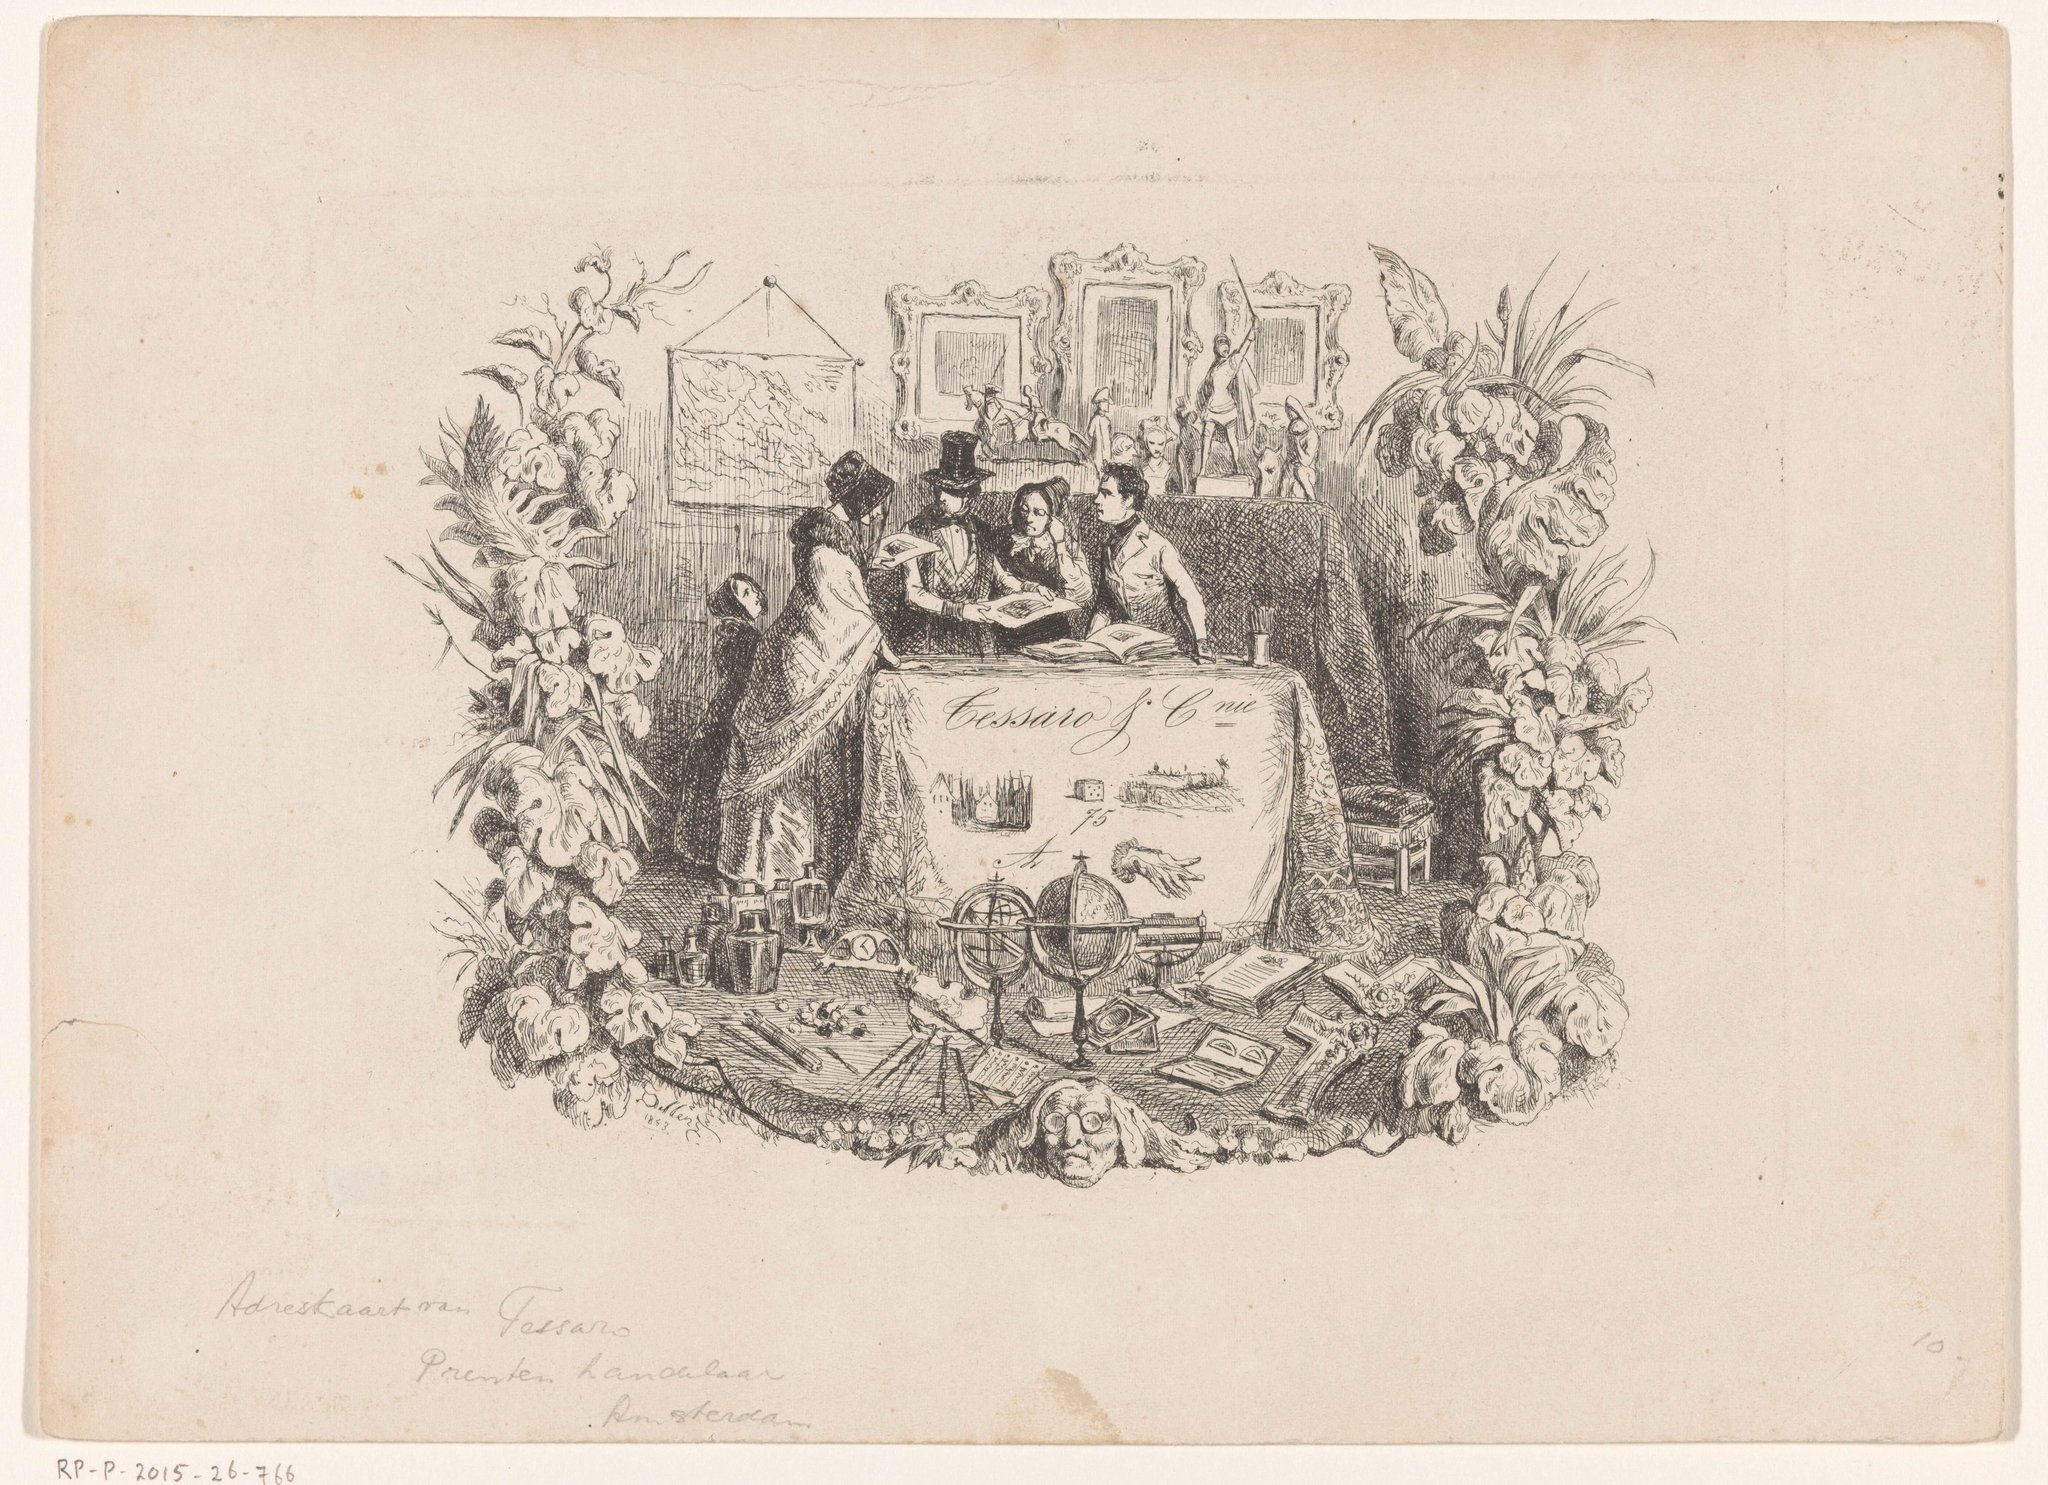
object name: print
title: Interieur van prenthandel Tessaro & Compagnie te Gent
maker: adolphe alexandre dillens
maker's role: draughtsman, painter, print maker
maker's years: 1821-1877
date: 1842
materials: paper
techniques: etching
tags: print, e.g.: engraving, etching, lithograph, art dealer, globe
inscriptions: collector's mark: Lugt 4780, annotation: ‘Adreskaart van Tessaro prenten handelaar Amsterdam’, collector's mark: Lugt 2228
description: Twee mannen en twee vrouwen bekijken prenten en boeken rond een tafel, naast hen een jong meisje. Op tafel ligt een kleed met daarop een rebus. Op een kast staan beelden en tegen de wand hangen ingelijste werken, op de voorgrond verschillende objecten waaronder twee globes. In een decoratieve omlijsting bestaande uit planten.